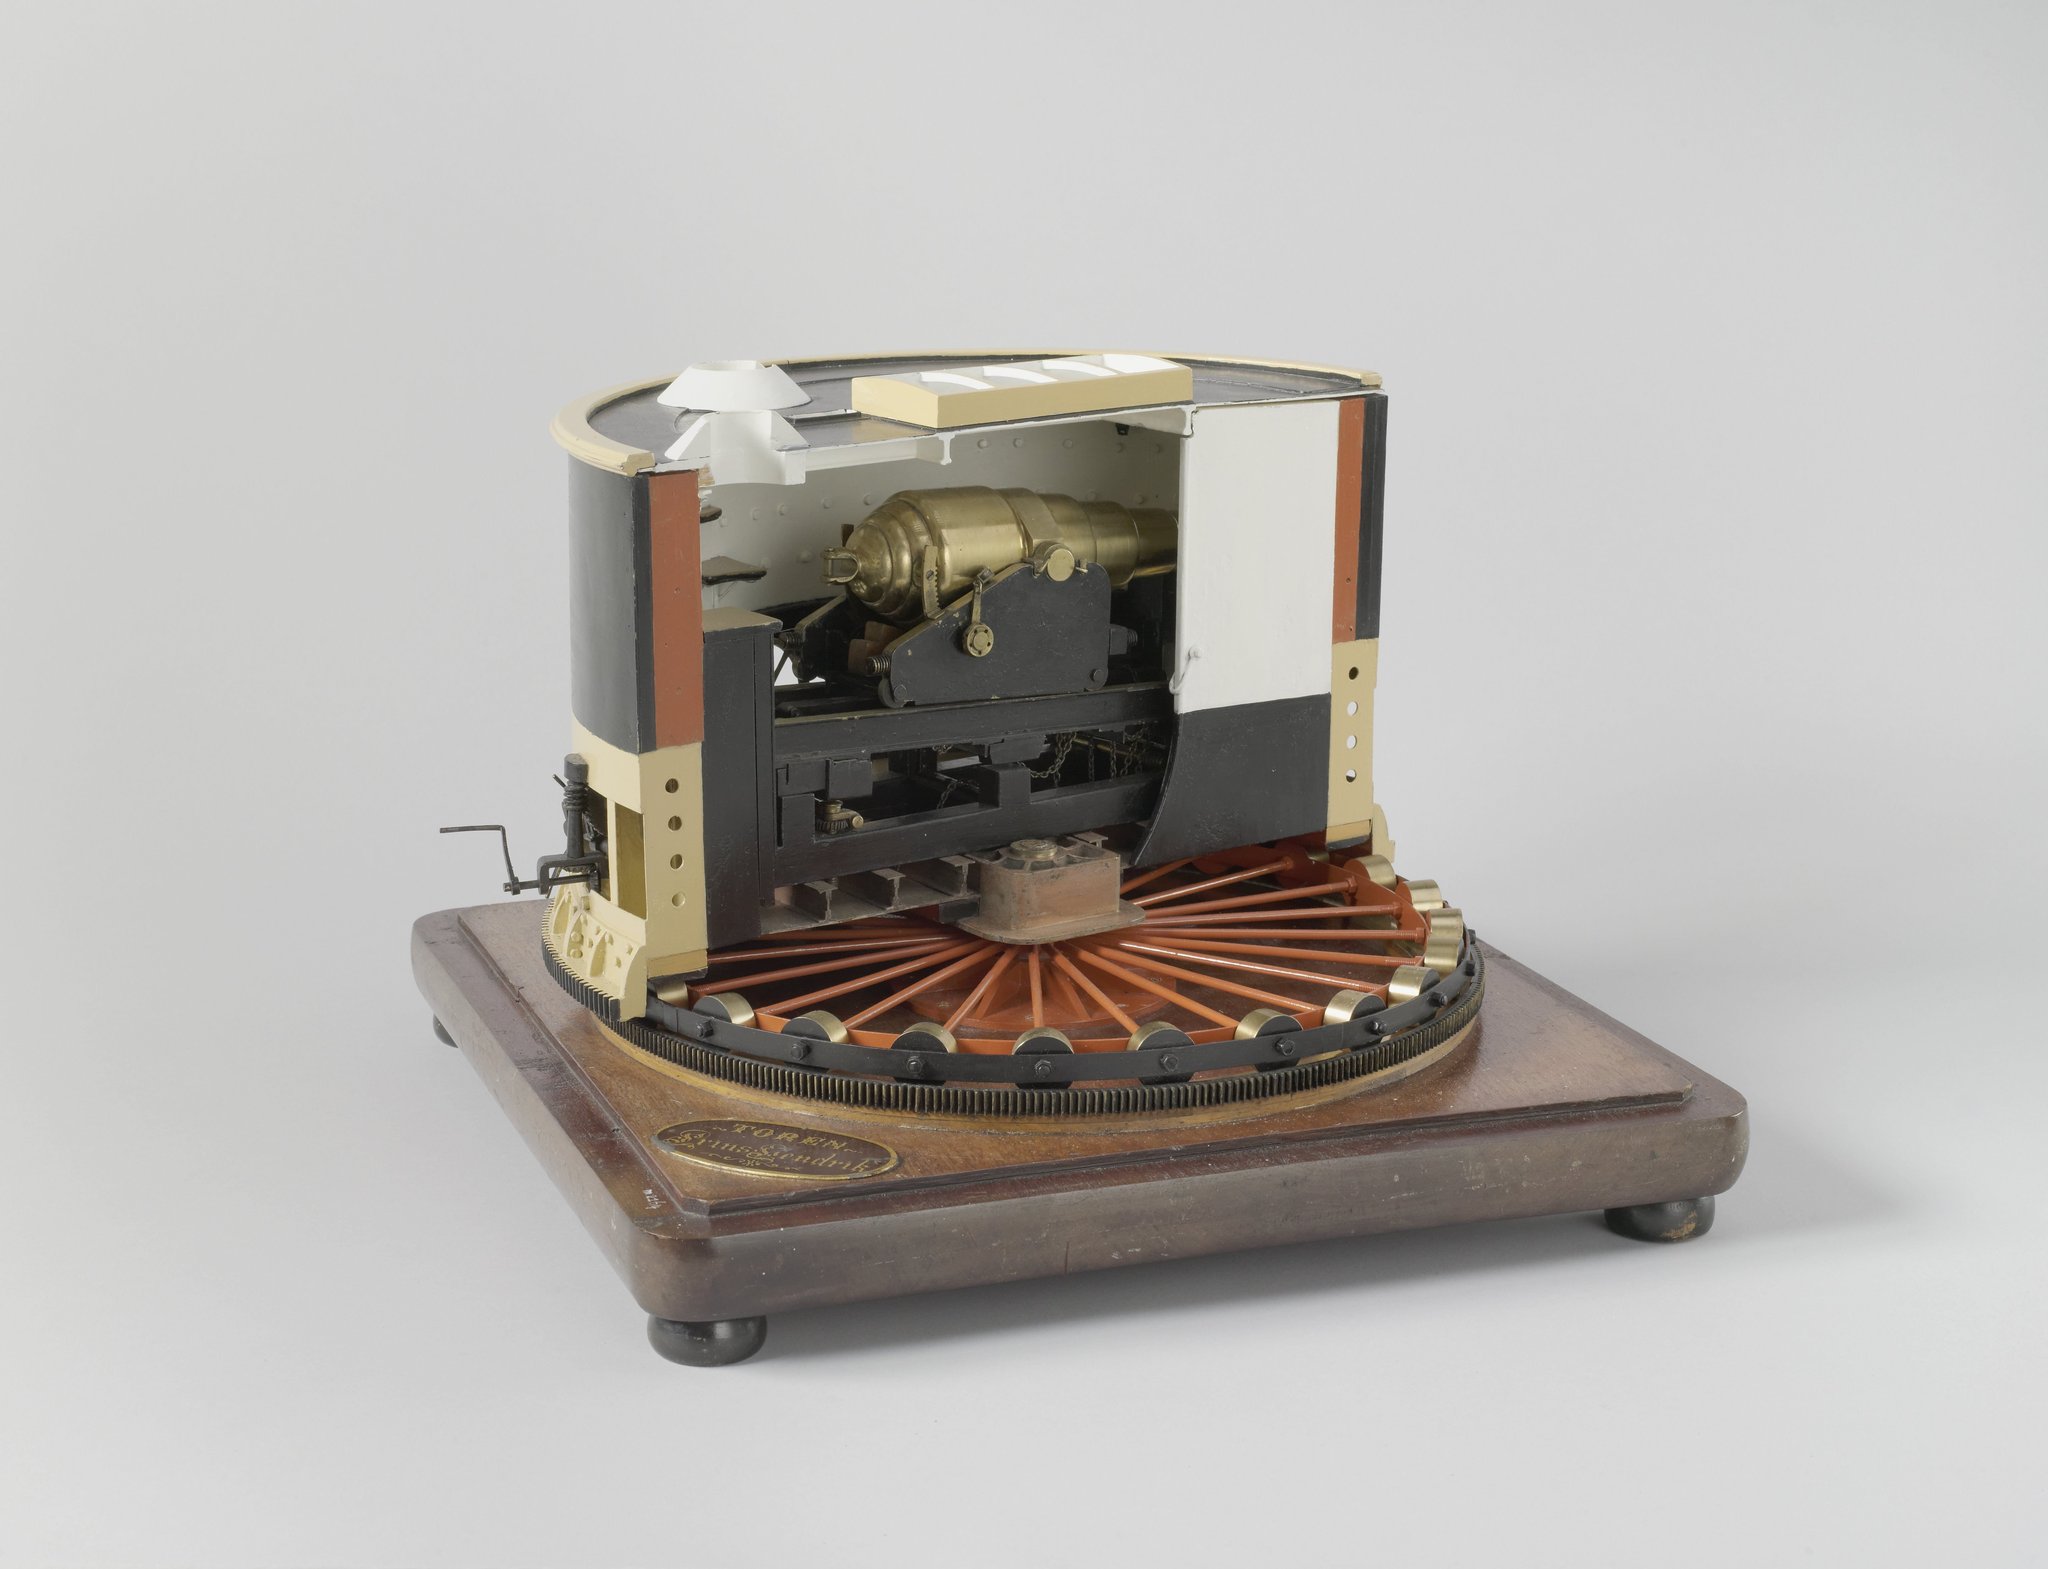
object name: demonstration model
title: Model of Half a Gun Turret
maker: adriaan rosel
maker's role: model maker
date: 1868-1869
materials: brass, iron, wood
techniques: polychromy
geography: willemsoord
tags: prins hendrik der nederlanden (schip)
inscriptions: inscription, on the base: ‘TOREN / Prins Hendrik’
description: This model offers a glimpse into the armoured turret on the turret ram Prins Hendrik der Nederlanden, the Royal Netherlands Navy’s first ironclad ship. The vessel was built in 1866–1867 at the Laird Brothers yard in Britain, after a design by Laird and the Dutch engineer B.J. Tideman. The Prins Hendrik der Nederlanden was fitted with two of these turrets, each housing two guns with a 23 cm calibre.